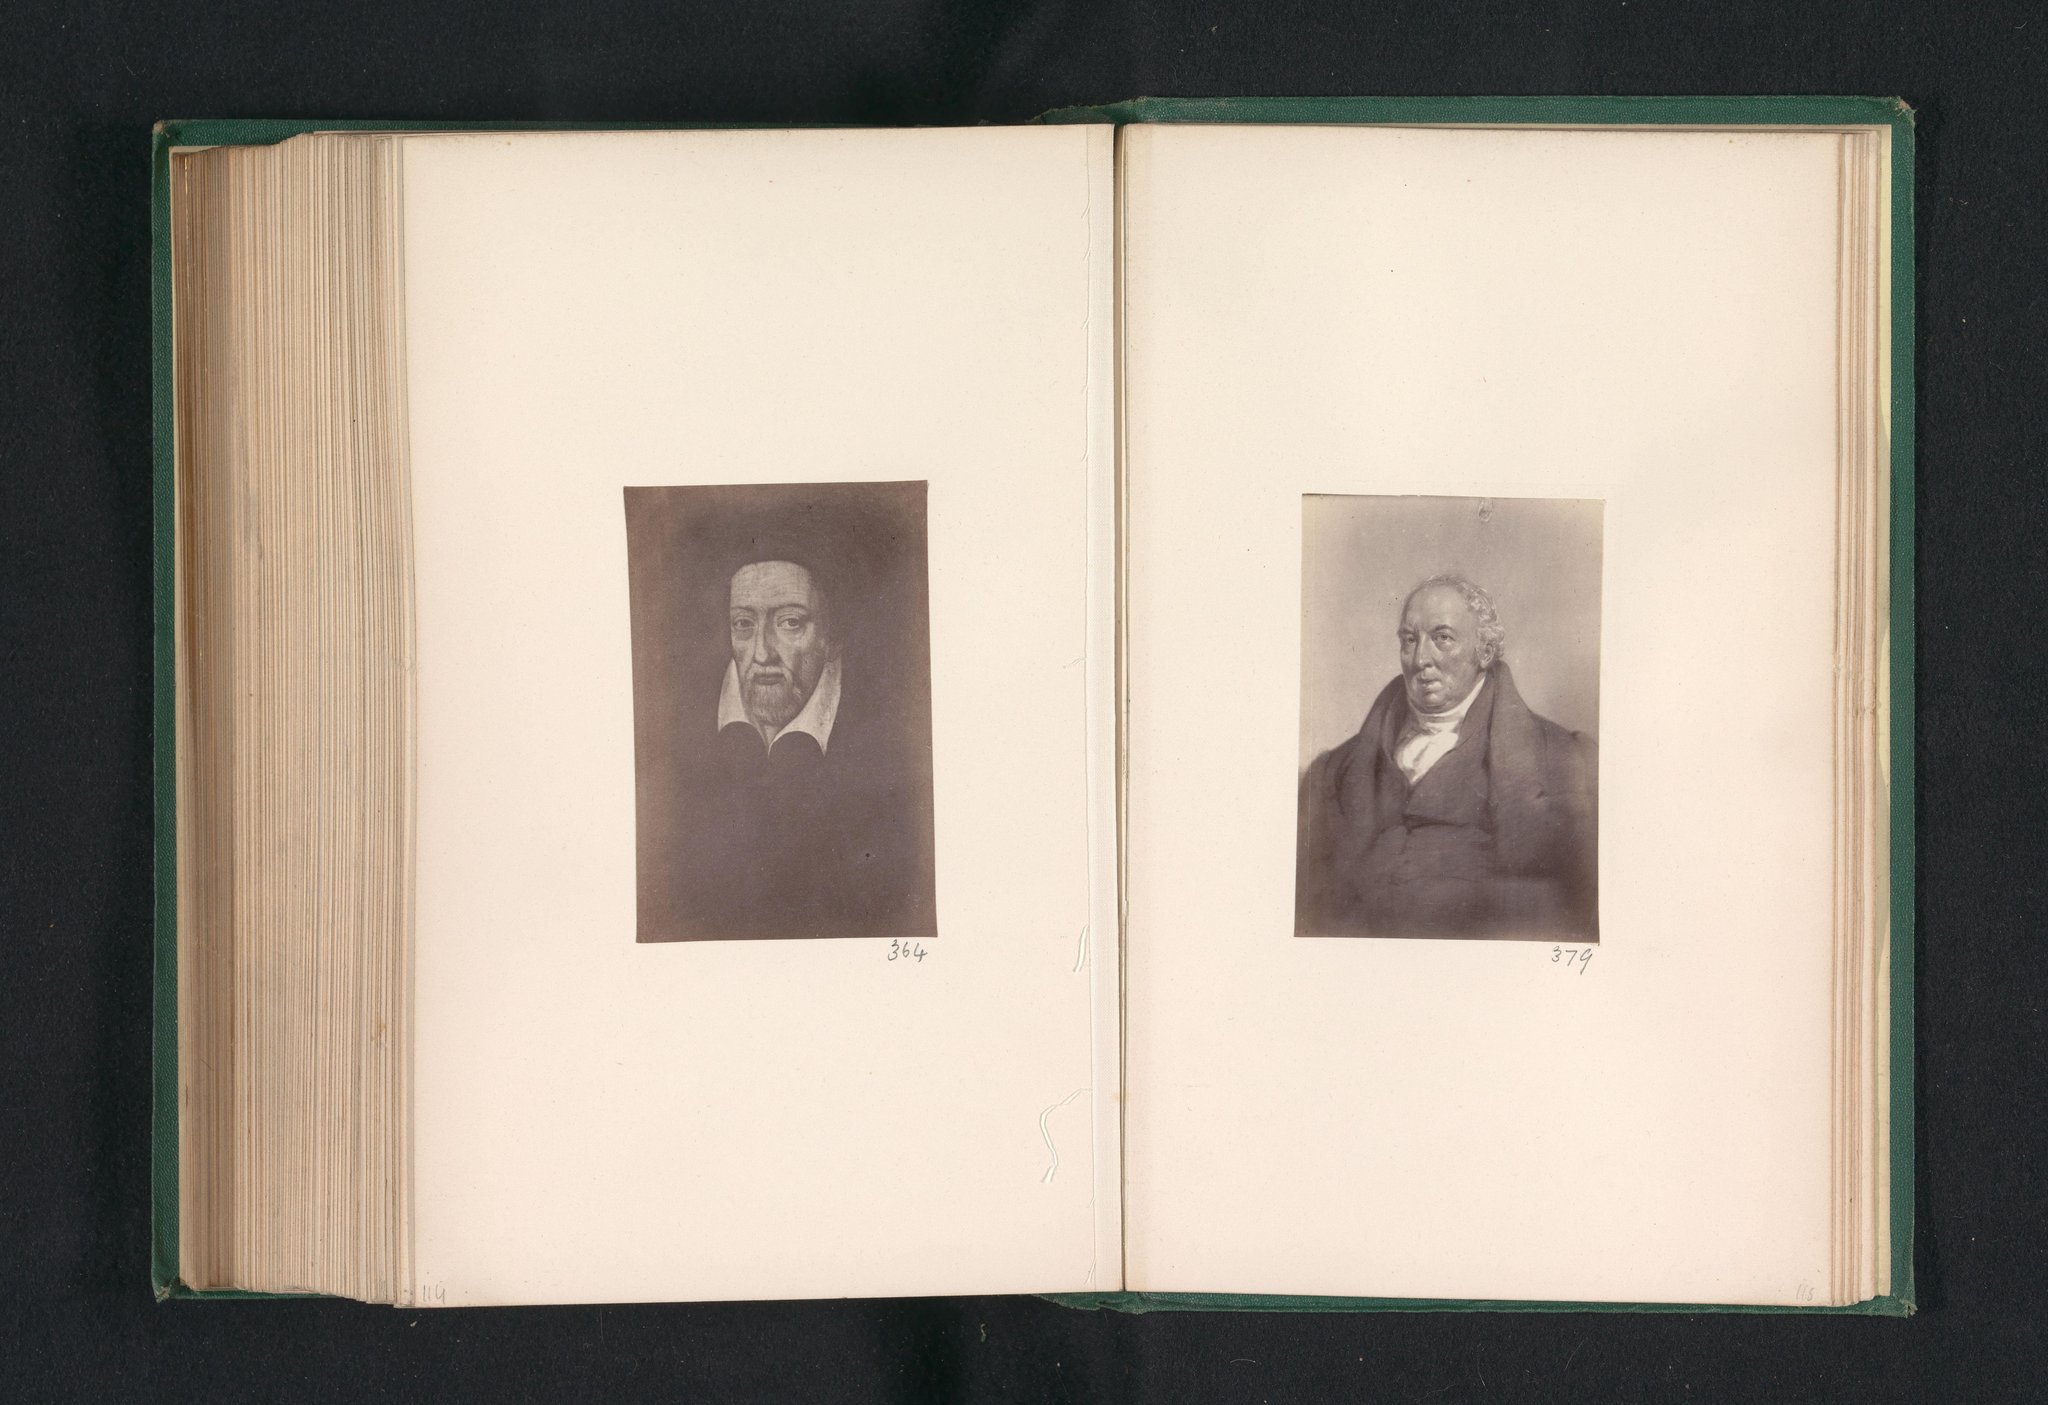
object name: page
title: Fotoreproductie van een schilderij, voorstellende een portret van George Buchanan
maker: thomas annan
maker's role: fotograaf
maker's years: 1829-1887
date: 1863-1868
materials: photographic support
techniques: albumen print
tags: george buchanan, historical persons (portraits and scenes from the life) (+ (full) bust portrait)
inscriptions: number: ‘364’